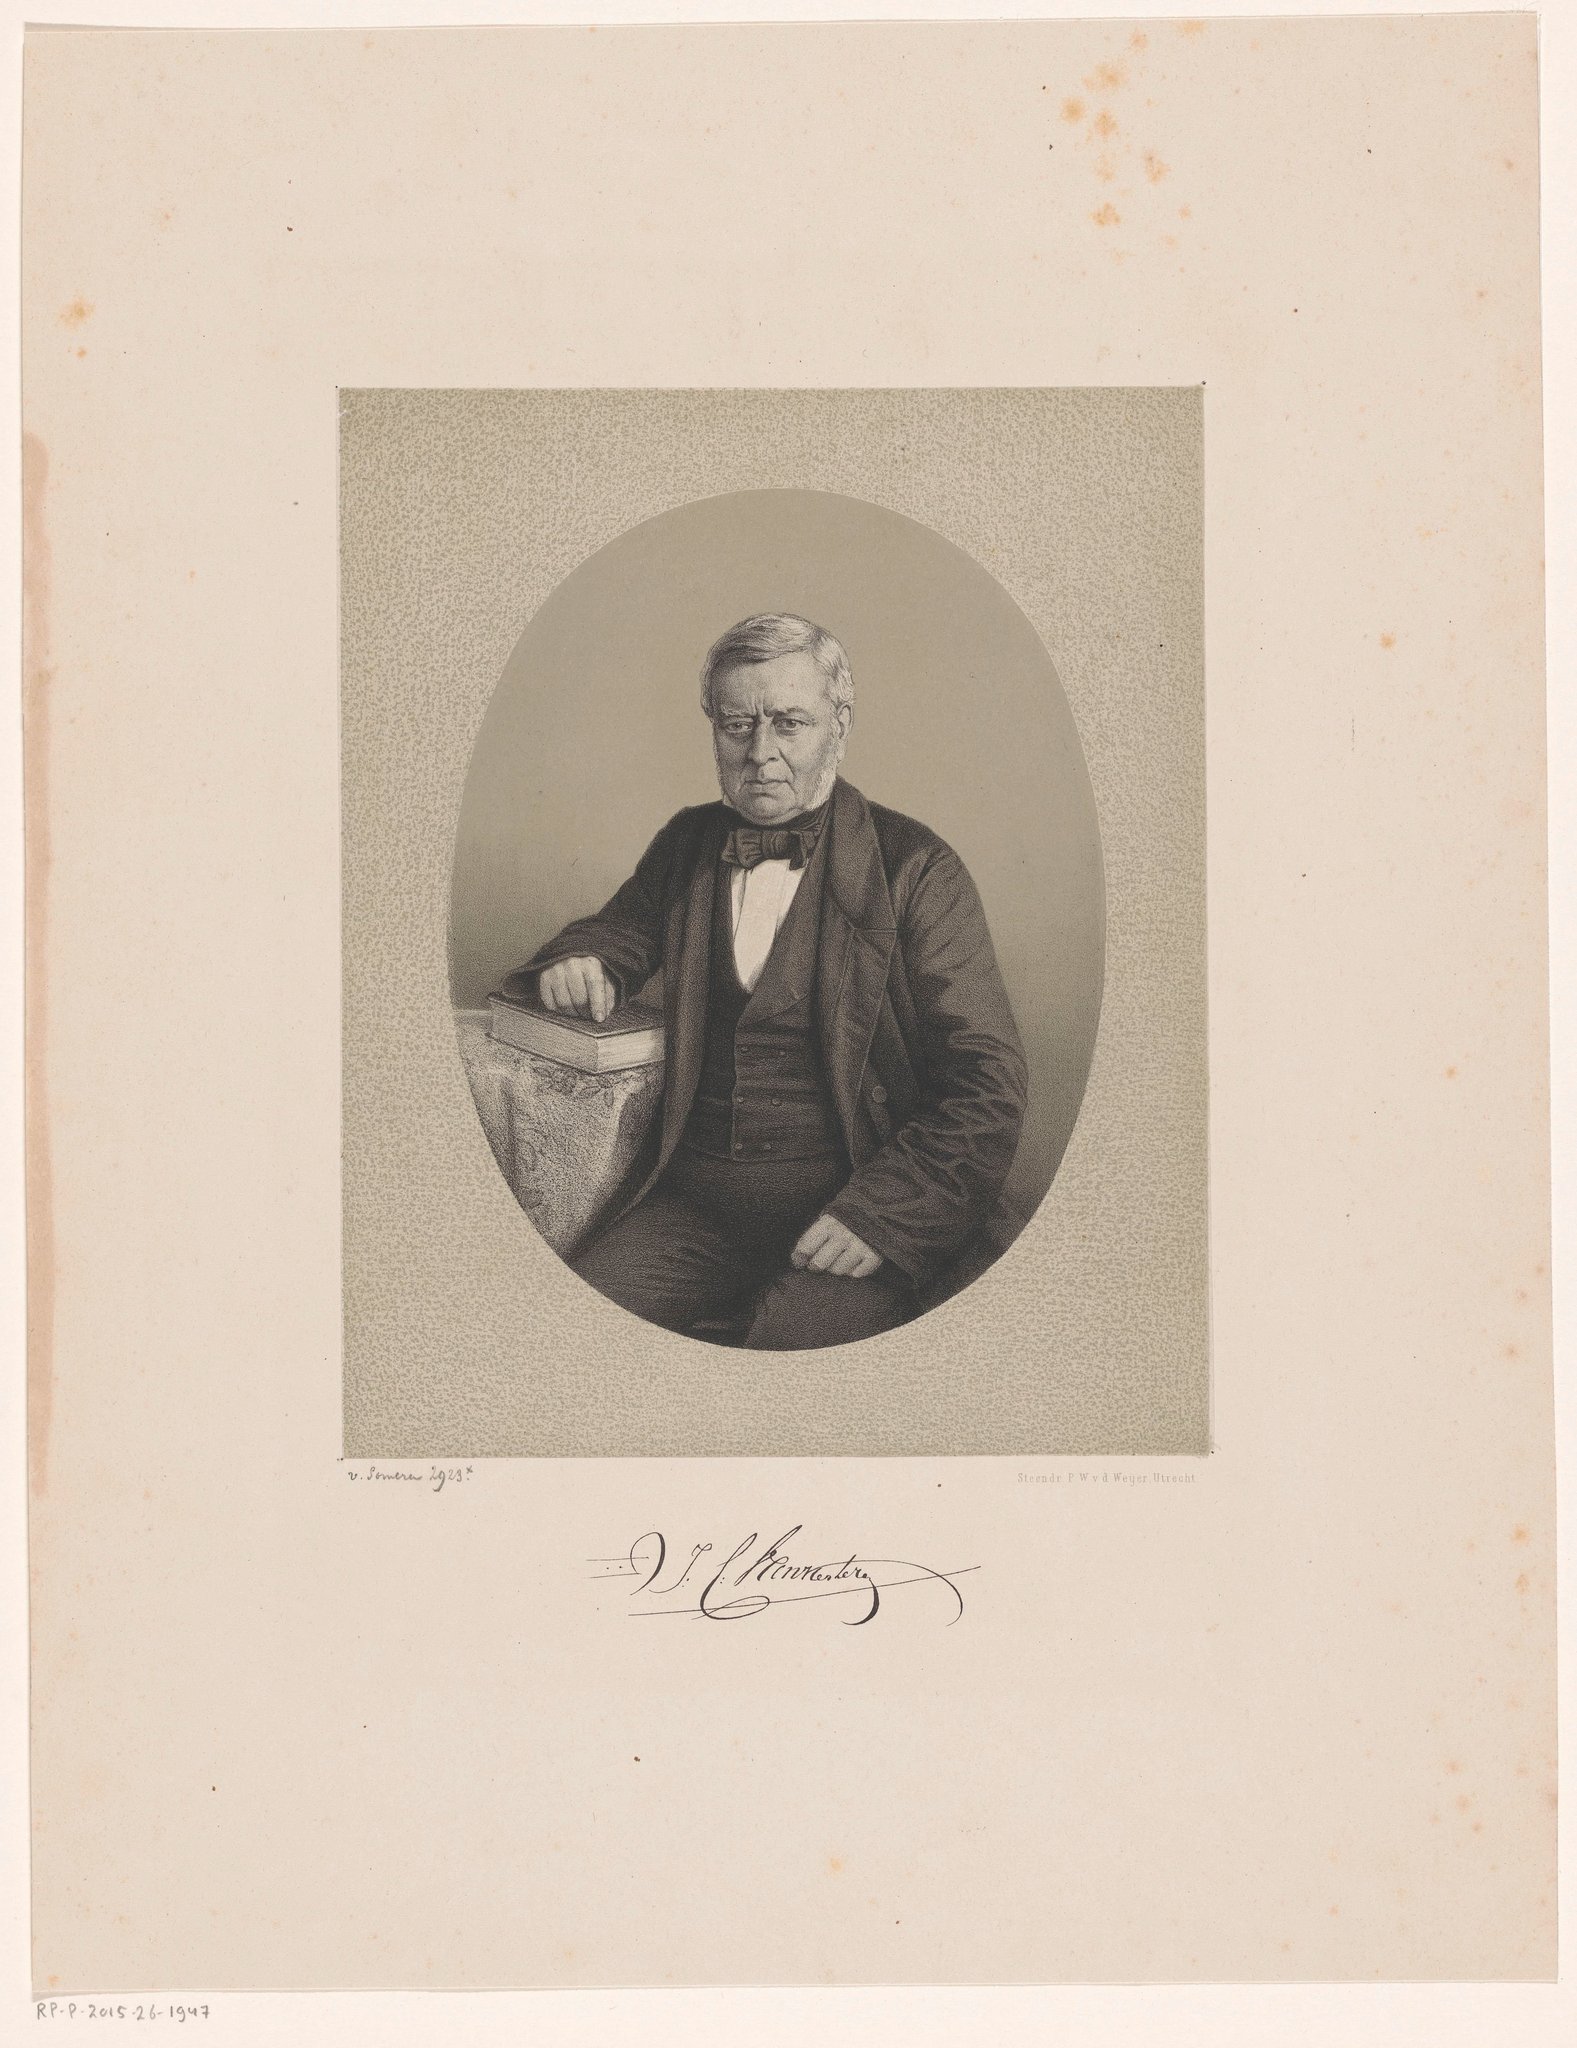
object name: print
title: Portret van Johannes Christoffel van Kesteren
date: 1842-1900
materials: paper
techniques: tone lithography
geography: utrecht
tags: amsterdam, publisher, johannes christoffel van kesteren, book-shop, bookseller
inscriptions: collector's mark: Lugt 2228, collector's mark: Lugt 4780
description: Portret van Johannes Christoffel van Kesteren, boekhandelaar en uitgever te Amsterdam. Onder het portret de signatuur van de geportretteerde.